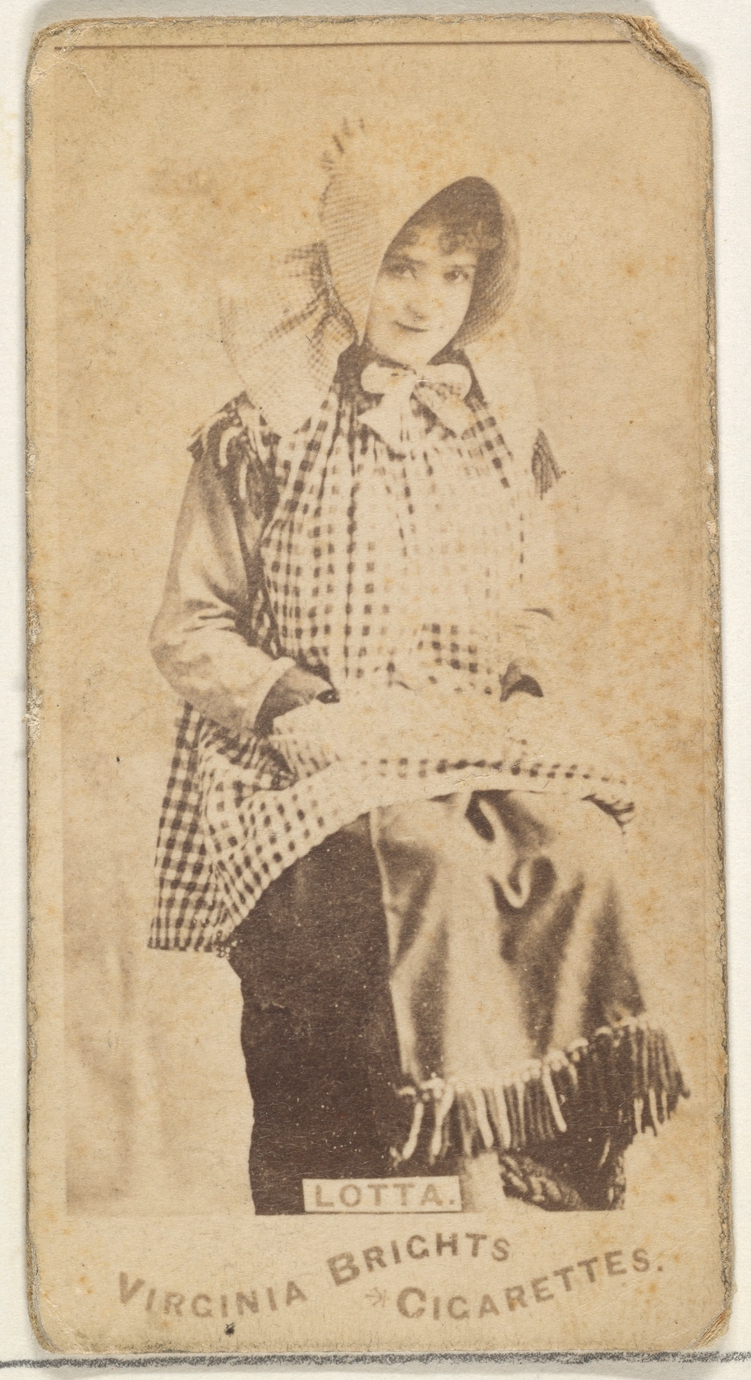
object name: photograph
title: Lotta, from the Actors and Actresses series (N45, Type 1) for Virginia Brights Cigarettes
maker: allen & ginter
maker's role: publisher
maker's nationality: american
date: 1888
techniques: albumen silver print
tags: portraits,women,actresses